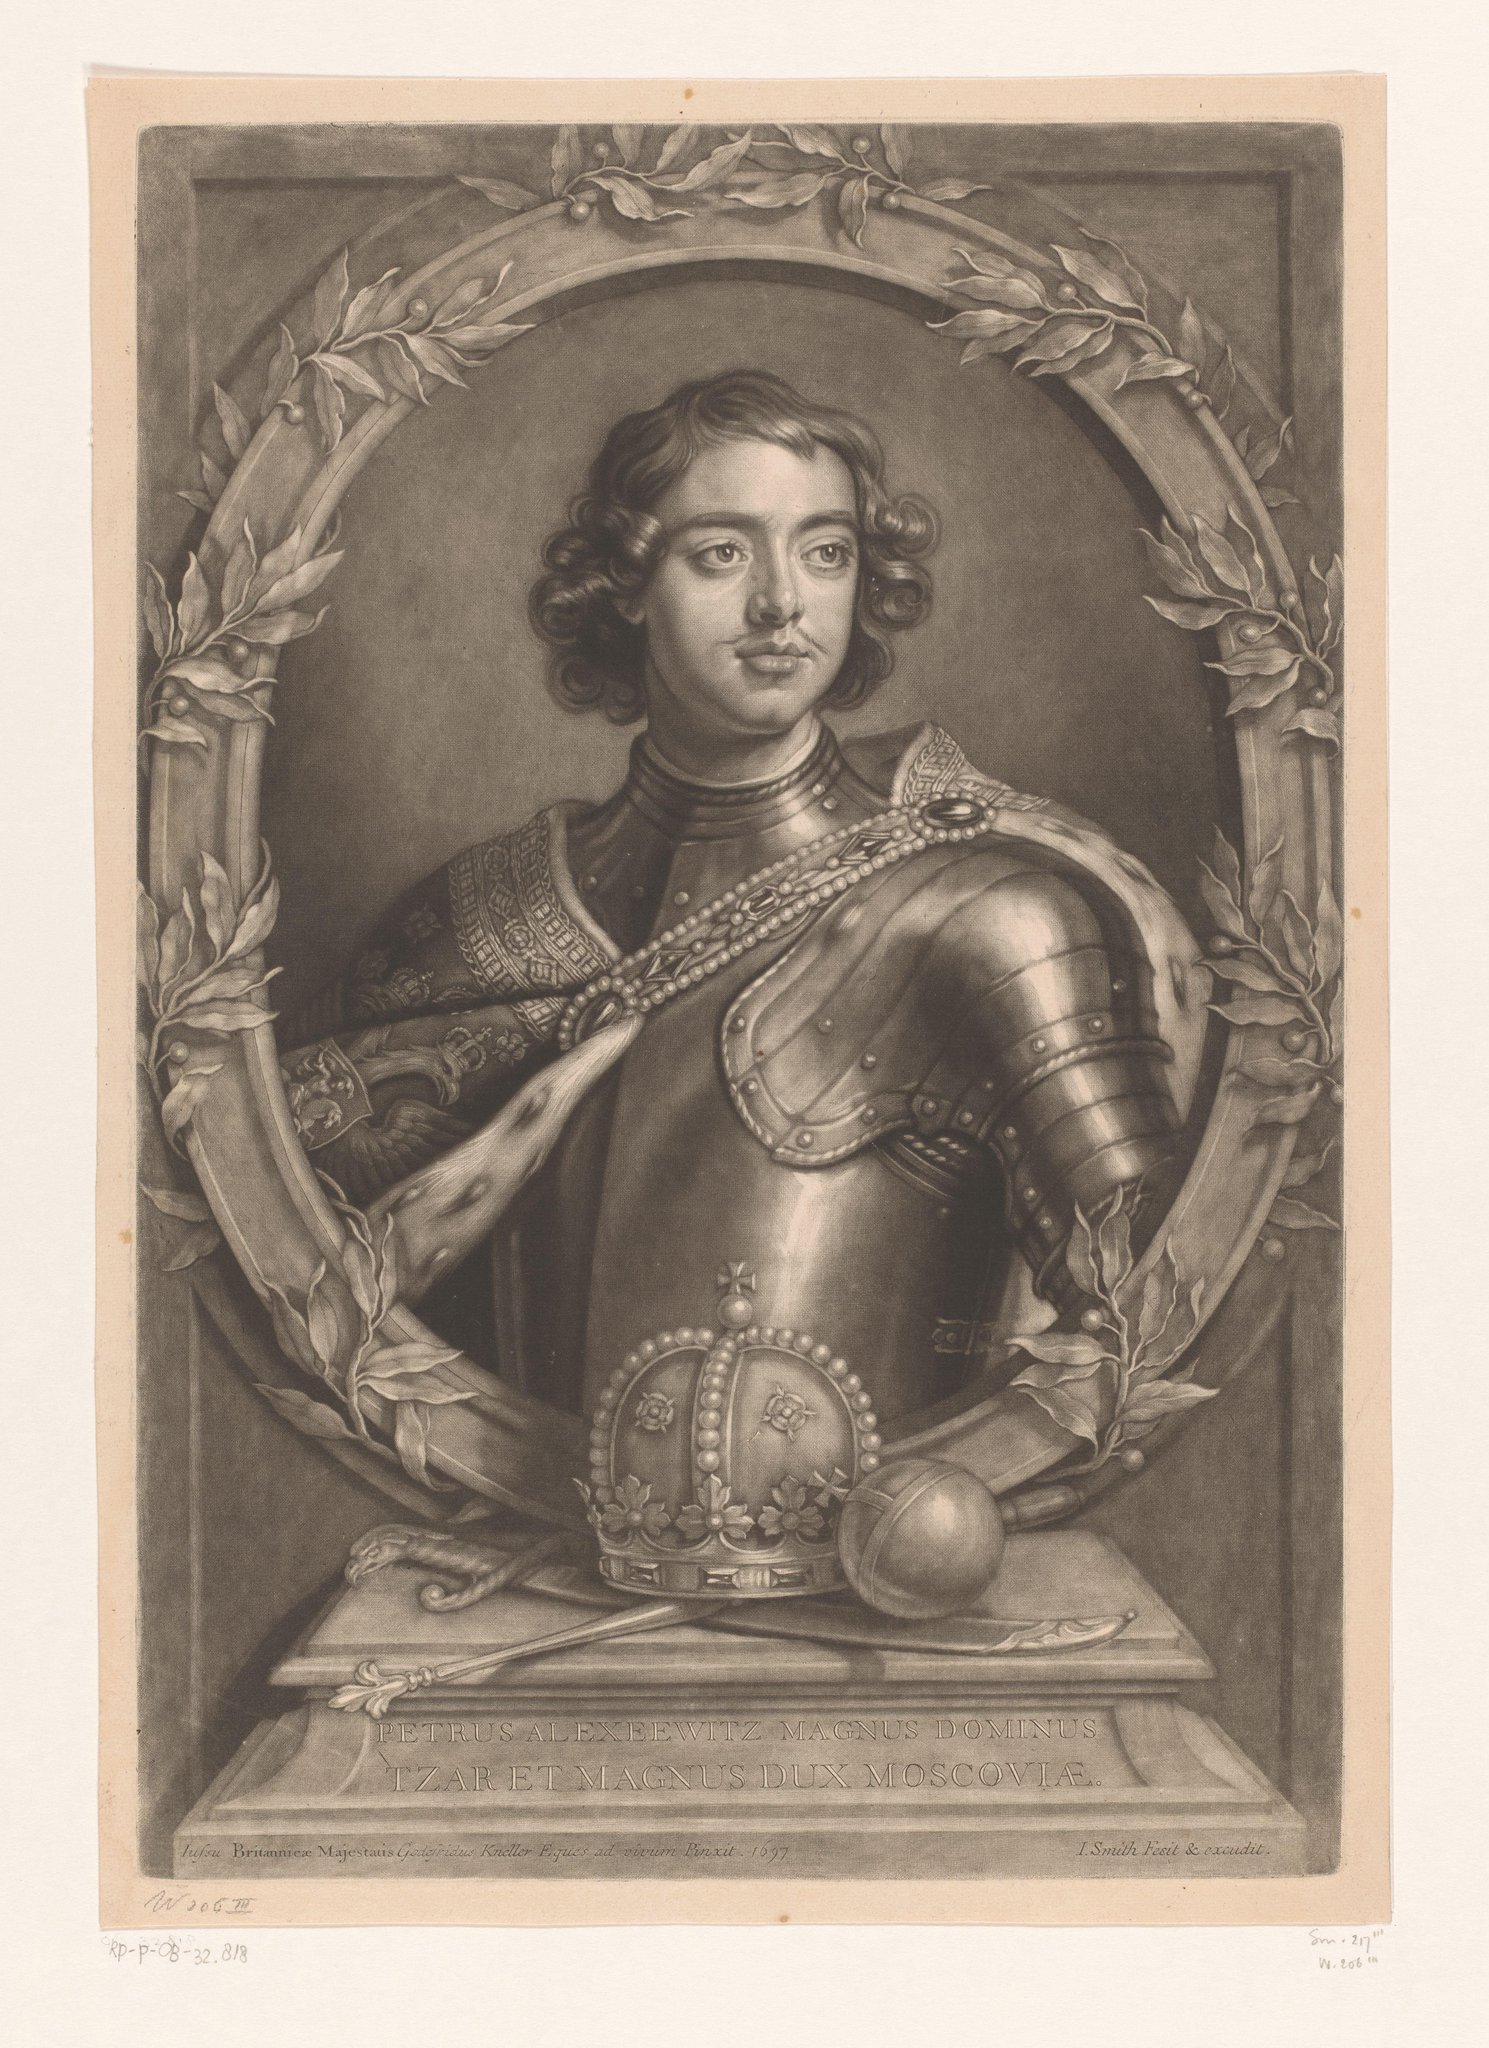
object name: print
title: Portret van Peter I de Grote, tsaar van Rusland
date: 1662-1742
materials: paper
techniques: engraving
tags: peter i de grote (tsaar van rusland), historical persons, emperor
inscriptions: collector's mark: Lugt 240